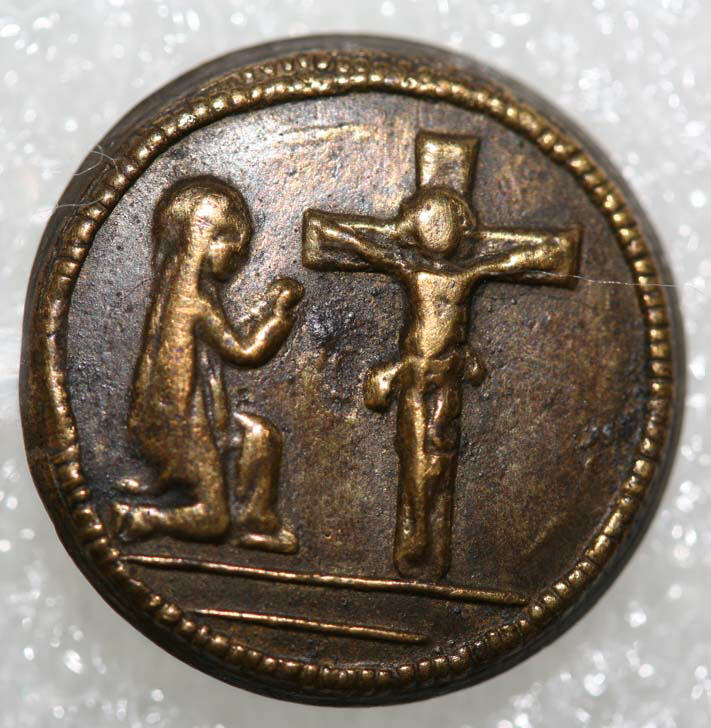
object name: button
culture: french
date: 1770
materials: brass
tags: christ,crucifixion